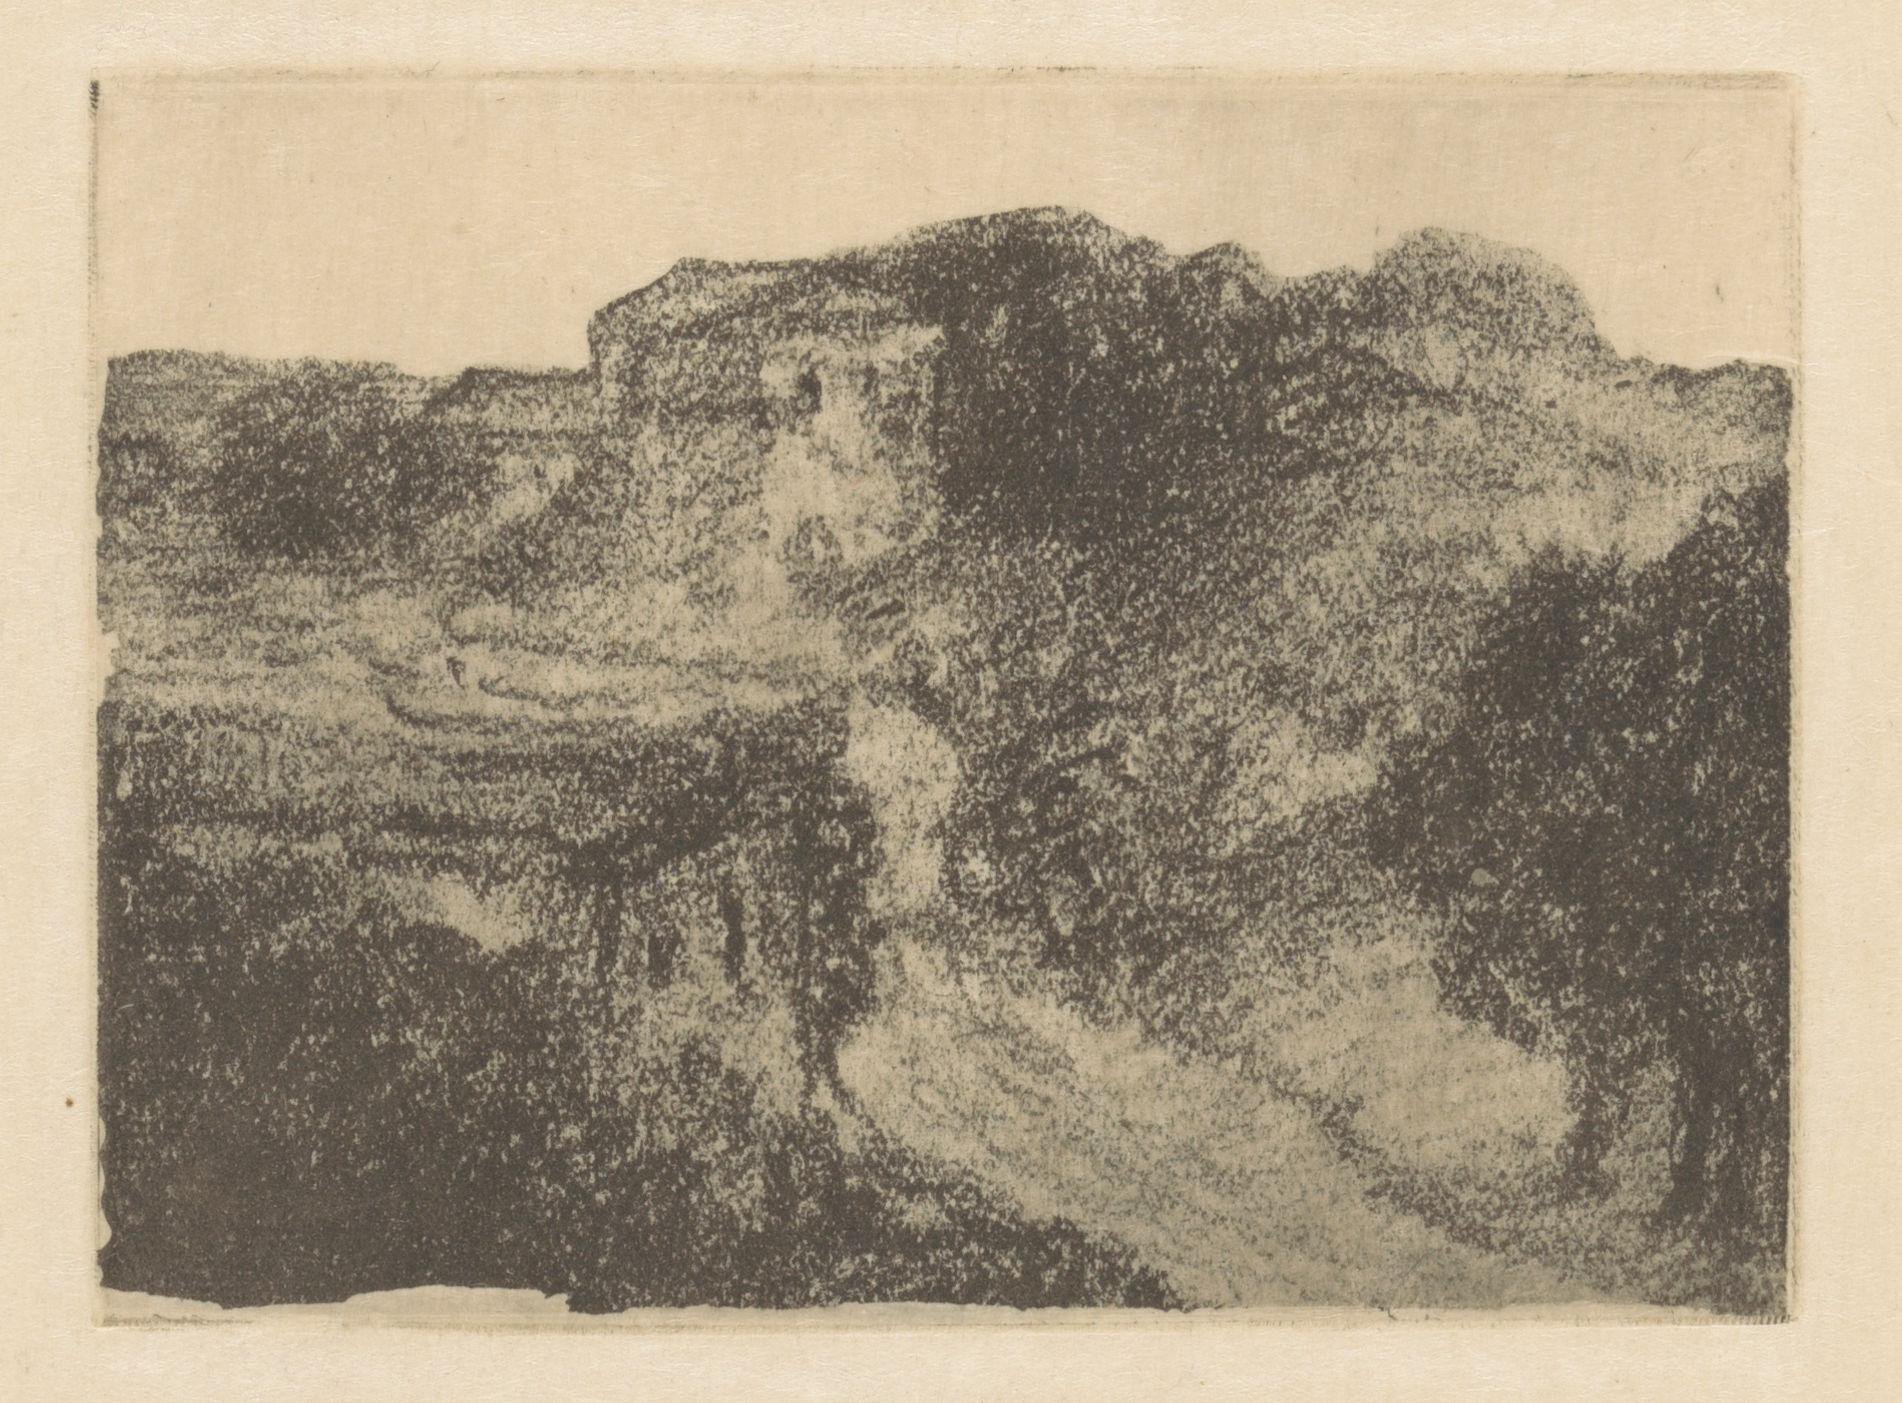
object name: print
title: Landschap met landhuis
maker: marius holleman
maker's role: draughtsman, print maker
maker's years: 1878-1926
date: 1904-1926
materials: paper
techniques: etching, intaglio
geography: groningen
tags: low hill country, rural housing, e.g. country-house, villa, cottage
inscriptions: collector's mark: Lugt 2228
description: Een weg loopt naar het landhuis op de heuvel. Rechts bomen.